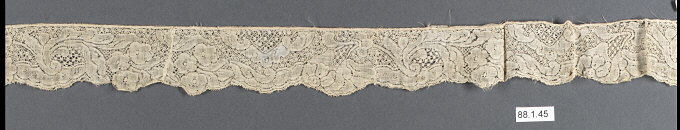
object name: edging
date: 1701-1733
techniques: lace